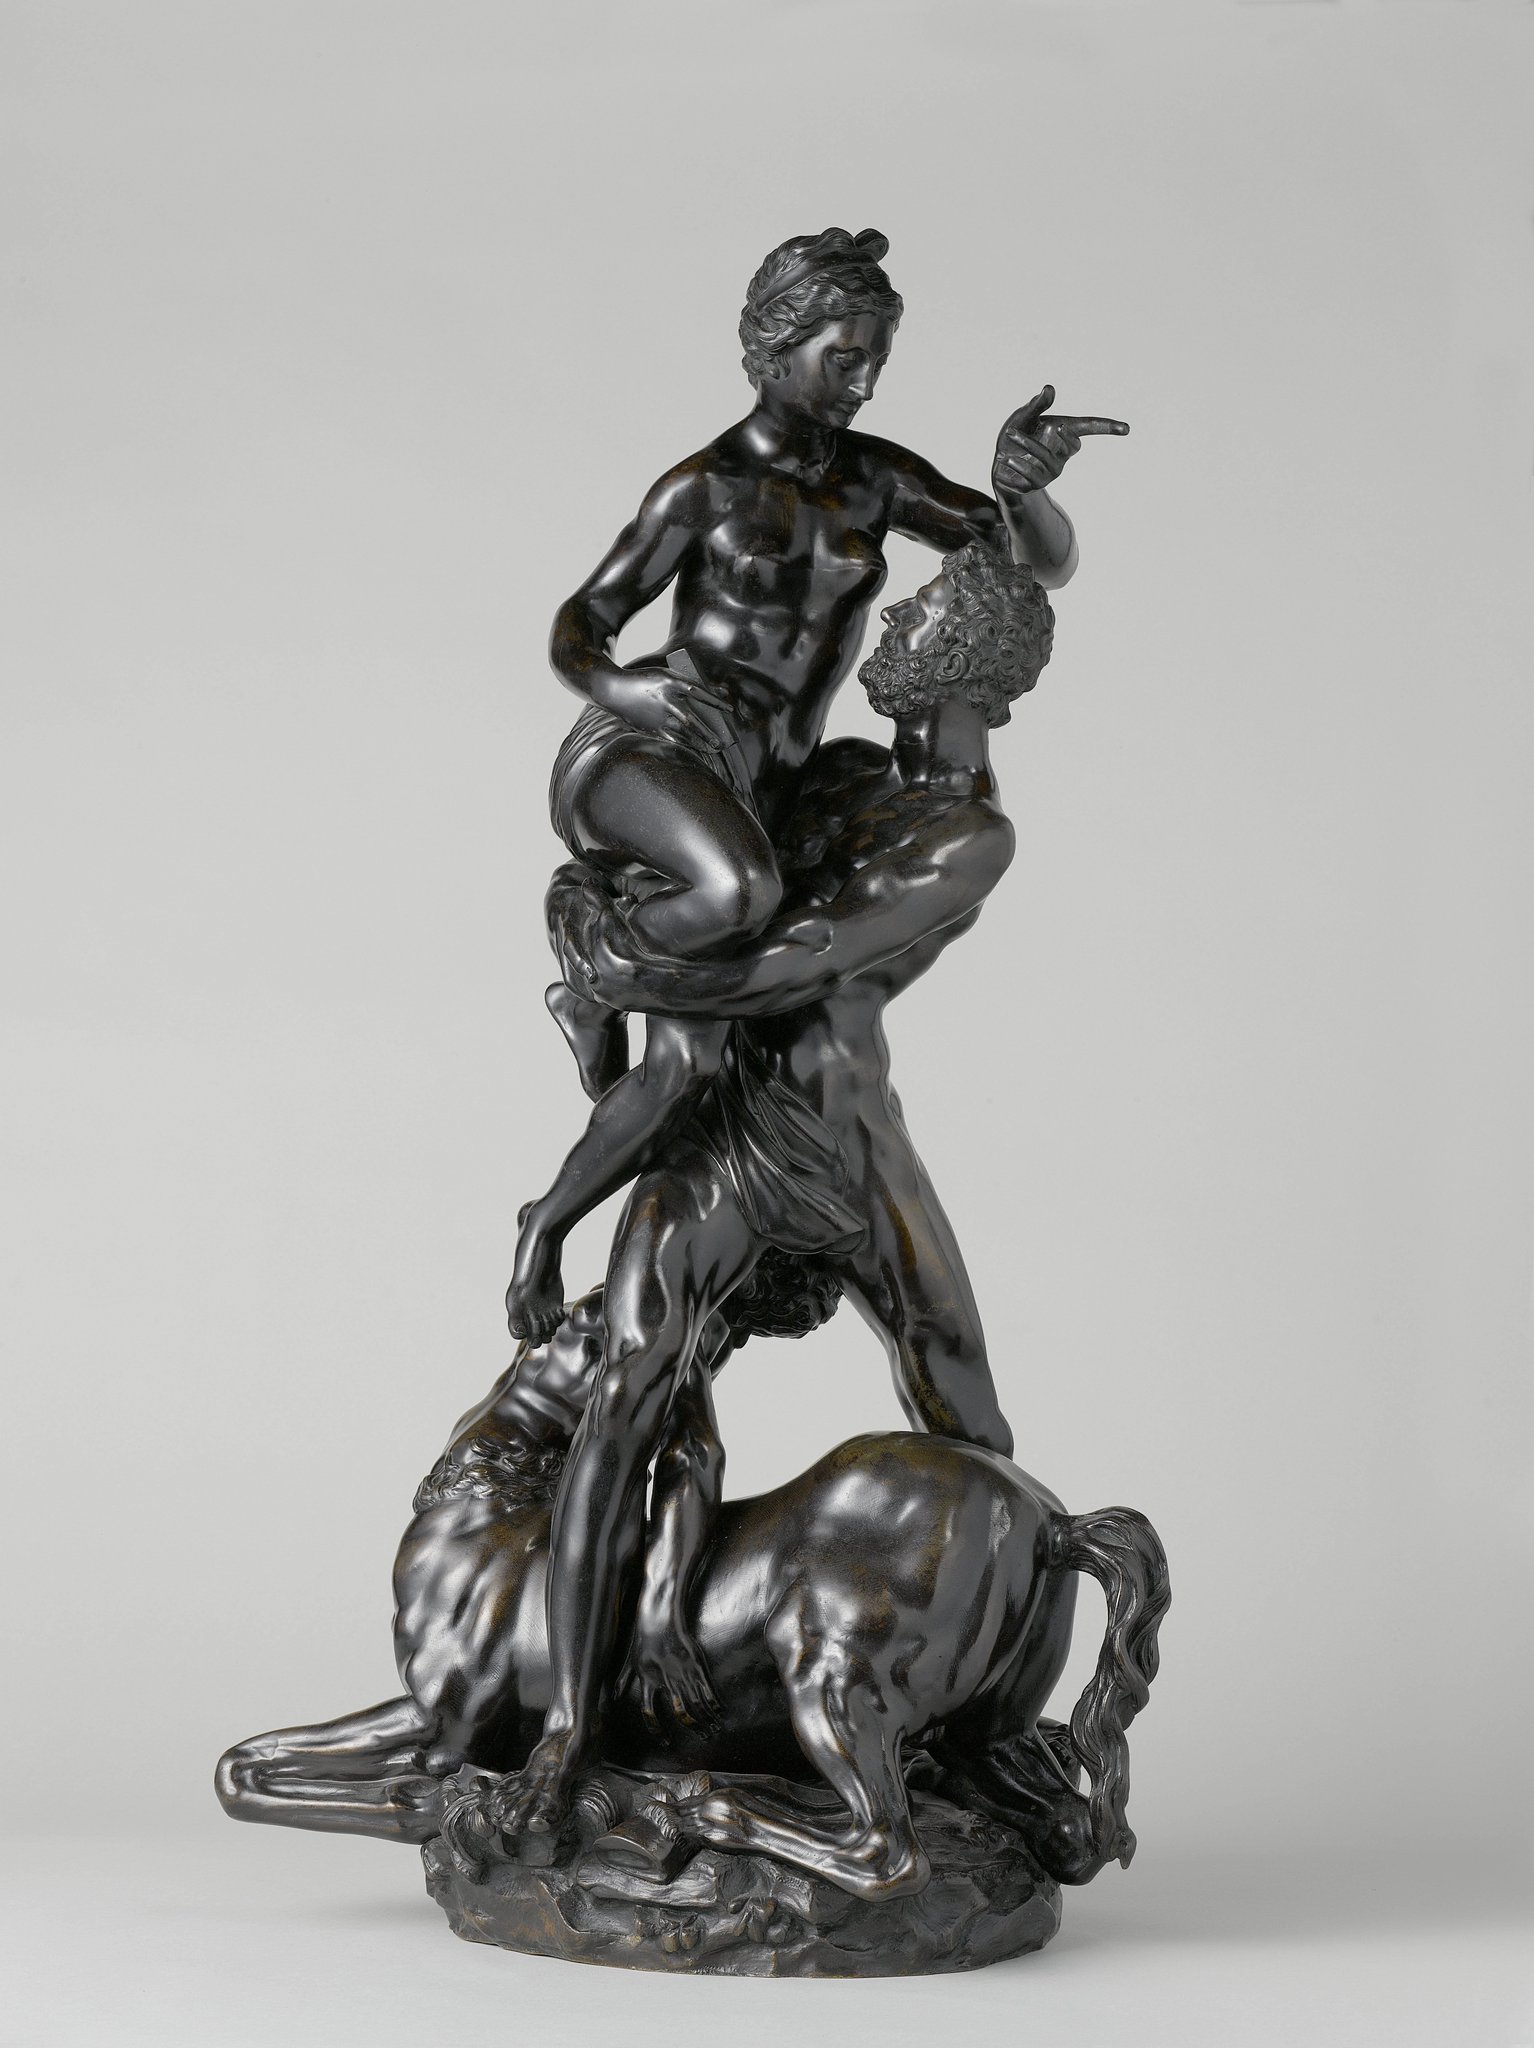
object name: sculpture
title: Hercules, Nessus and Deianeira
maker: charles crozatier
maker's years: 1795-1855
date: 1845-1850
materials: bronze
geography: paris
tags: hercules and deianira with the dying nessus